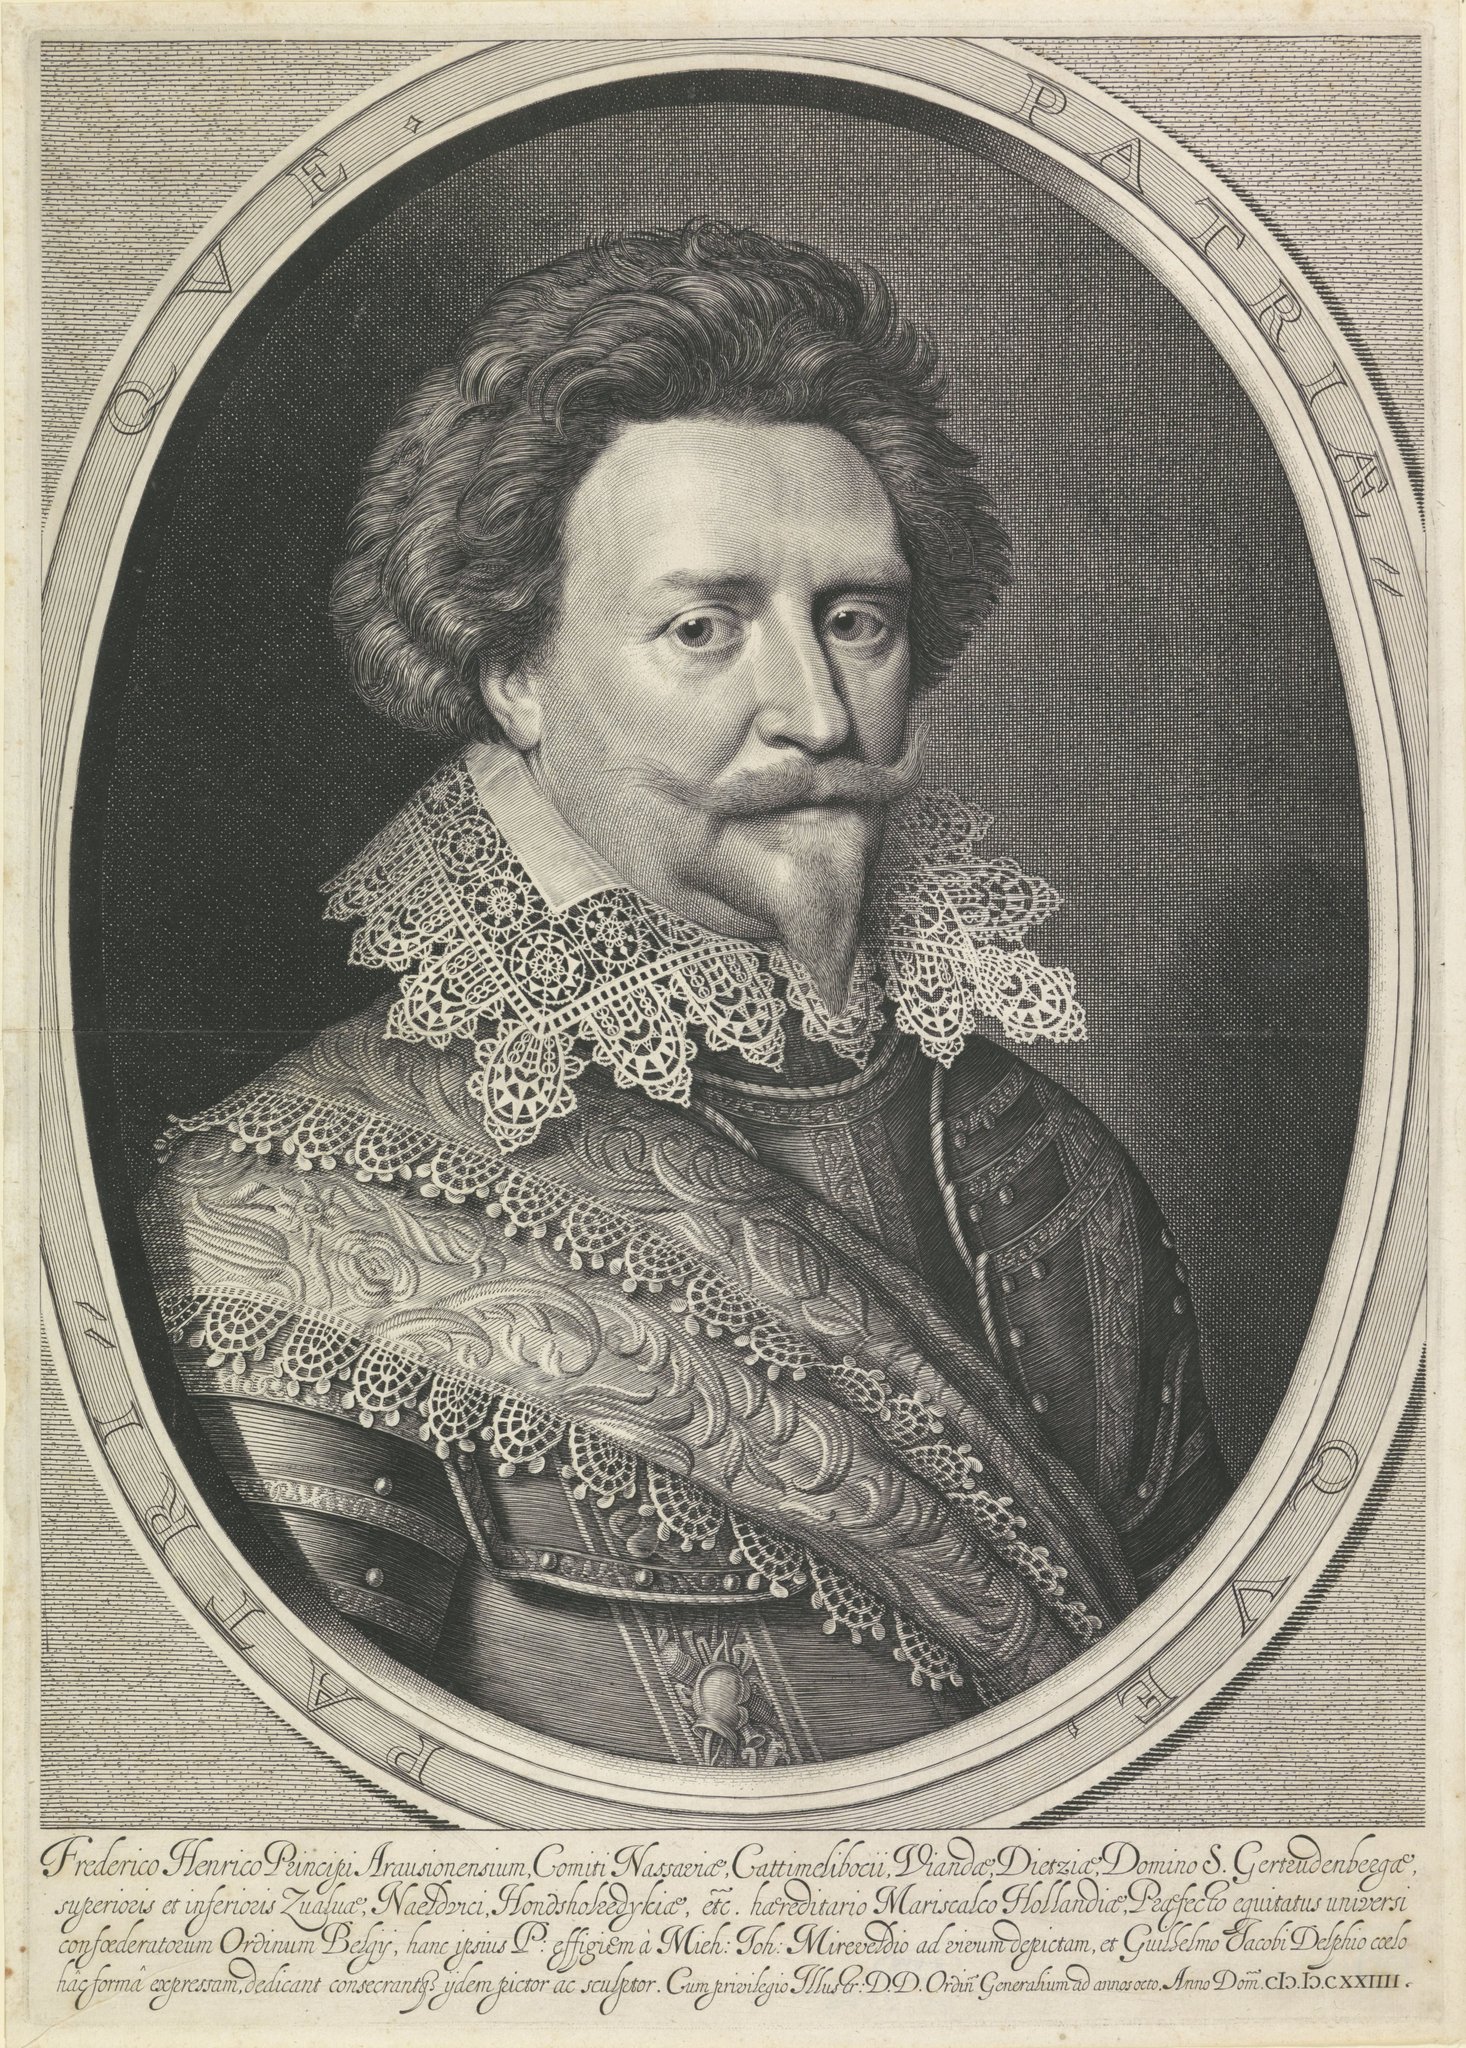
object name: print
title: Portret van Frederik Hendrik, prins van Oranje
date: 1624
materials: paper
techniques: engraving, etching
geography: delft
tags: the hague, frederick henry (prince of orange)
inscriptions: collector's mark: Lugt 963, collector's mark: Lugt 2228, collector's mark: Lugt 964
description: De hier vermelde titel verwijst naar de hoogst verkregen titel van de geportretteerde, niet per se naar de titel die de geportretteerde op deze voorstelling draagt.